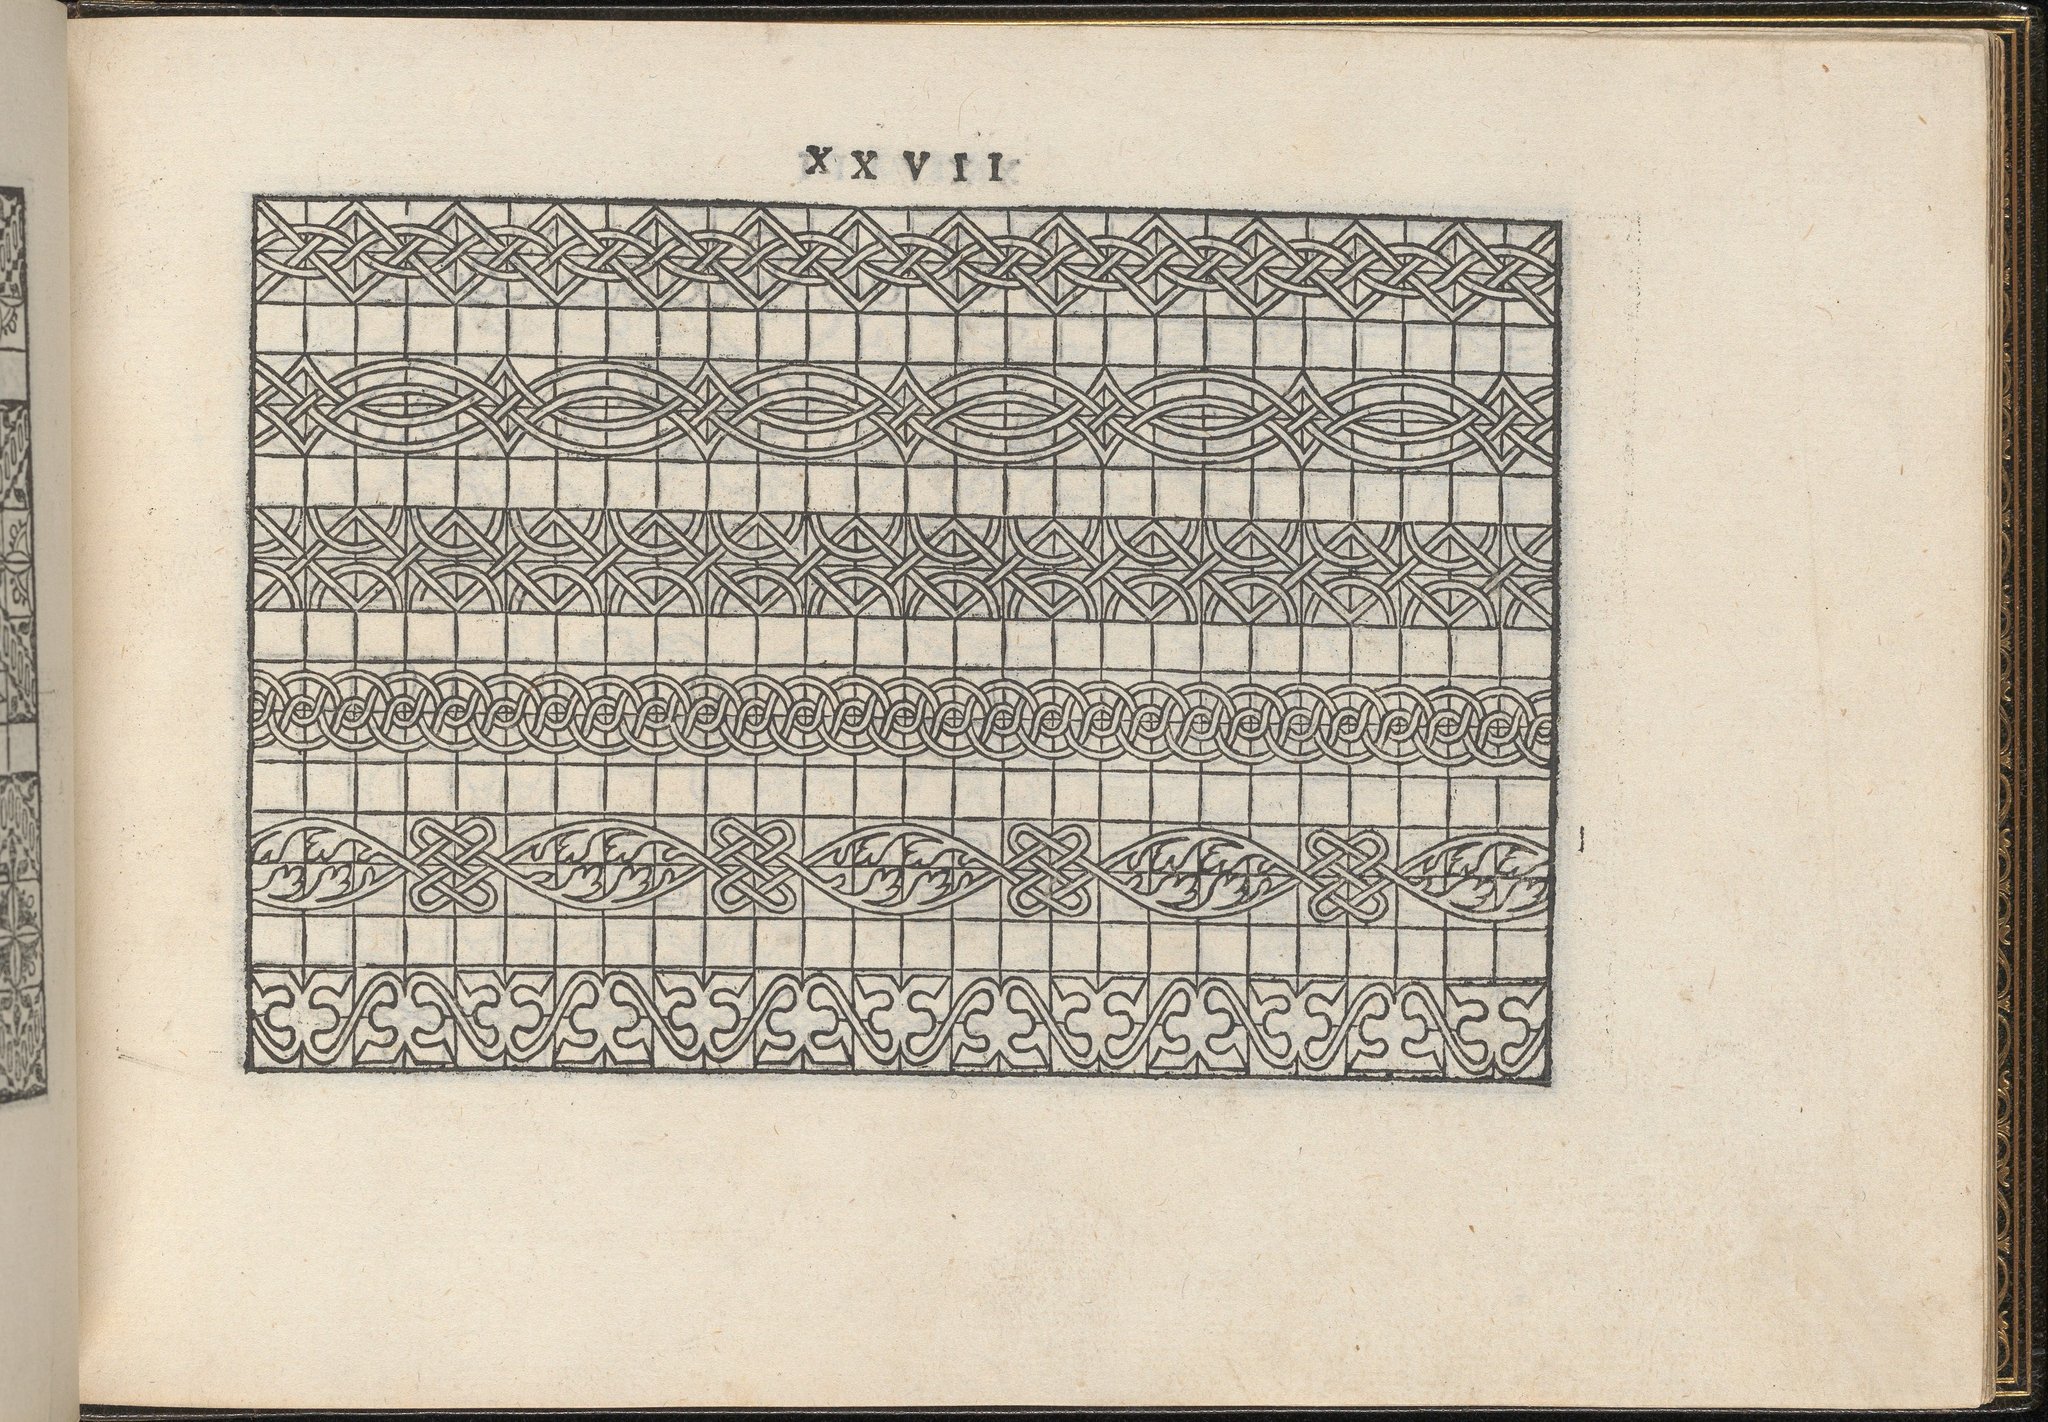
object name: book print ornament architecture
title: La Vera Perfettione del Disegno di varie sorti di recami, page 14 (recto)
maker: giovanni ostaus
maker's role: publisher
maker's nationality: italian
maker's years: 1507-1607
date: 1567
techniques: woodcut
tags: ornament